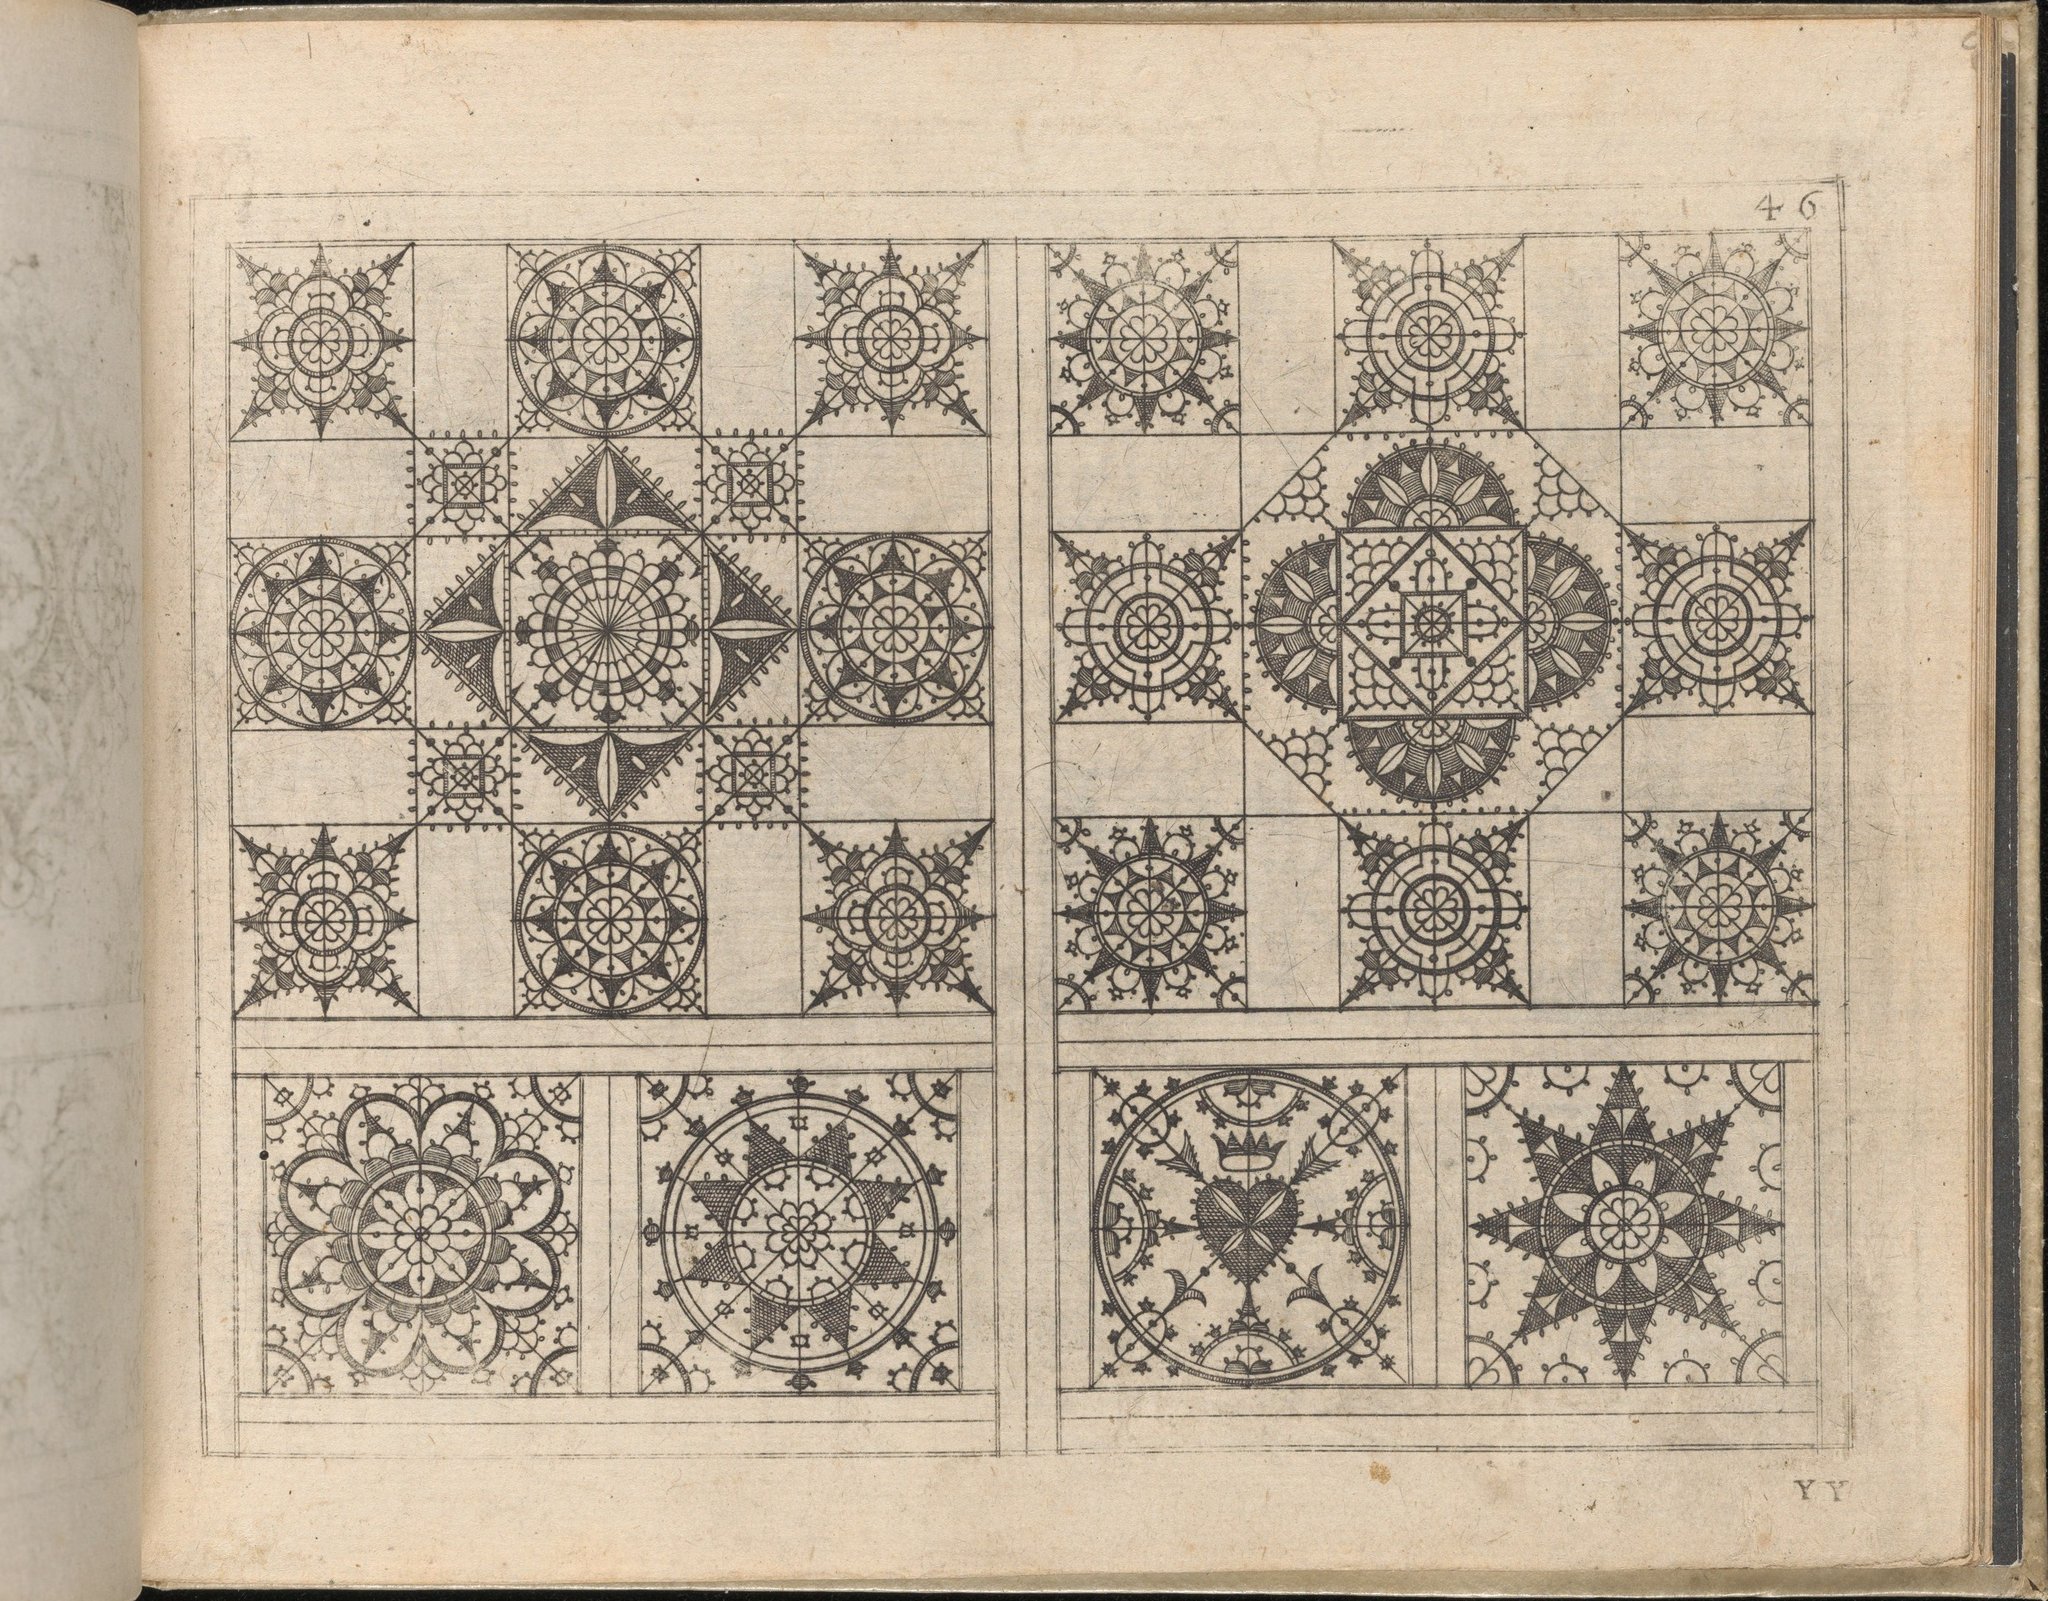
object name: book print ornament architecture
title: Newes Modelbuch in Kupffer (Page 55r)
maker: johann sibmacher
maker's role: artist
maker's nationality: german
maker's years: 1590-1611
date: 1604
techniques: etching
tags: ornament